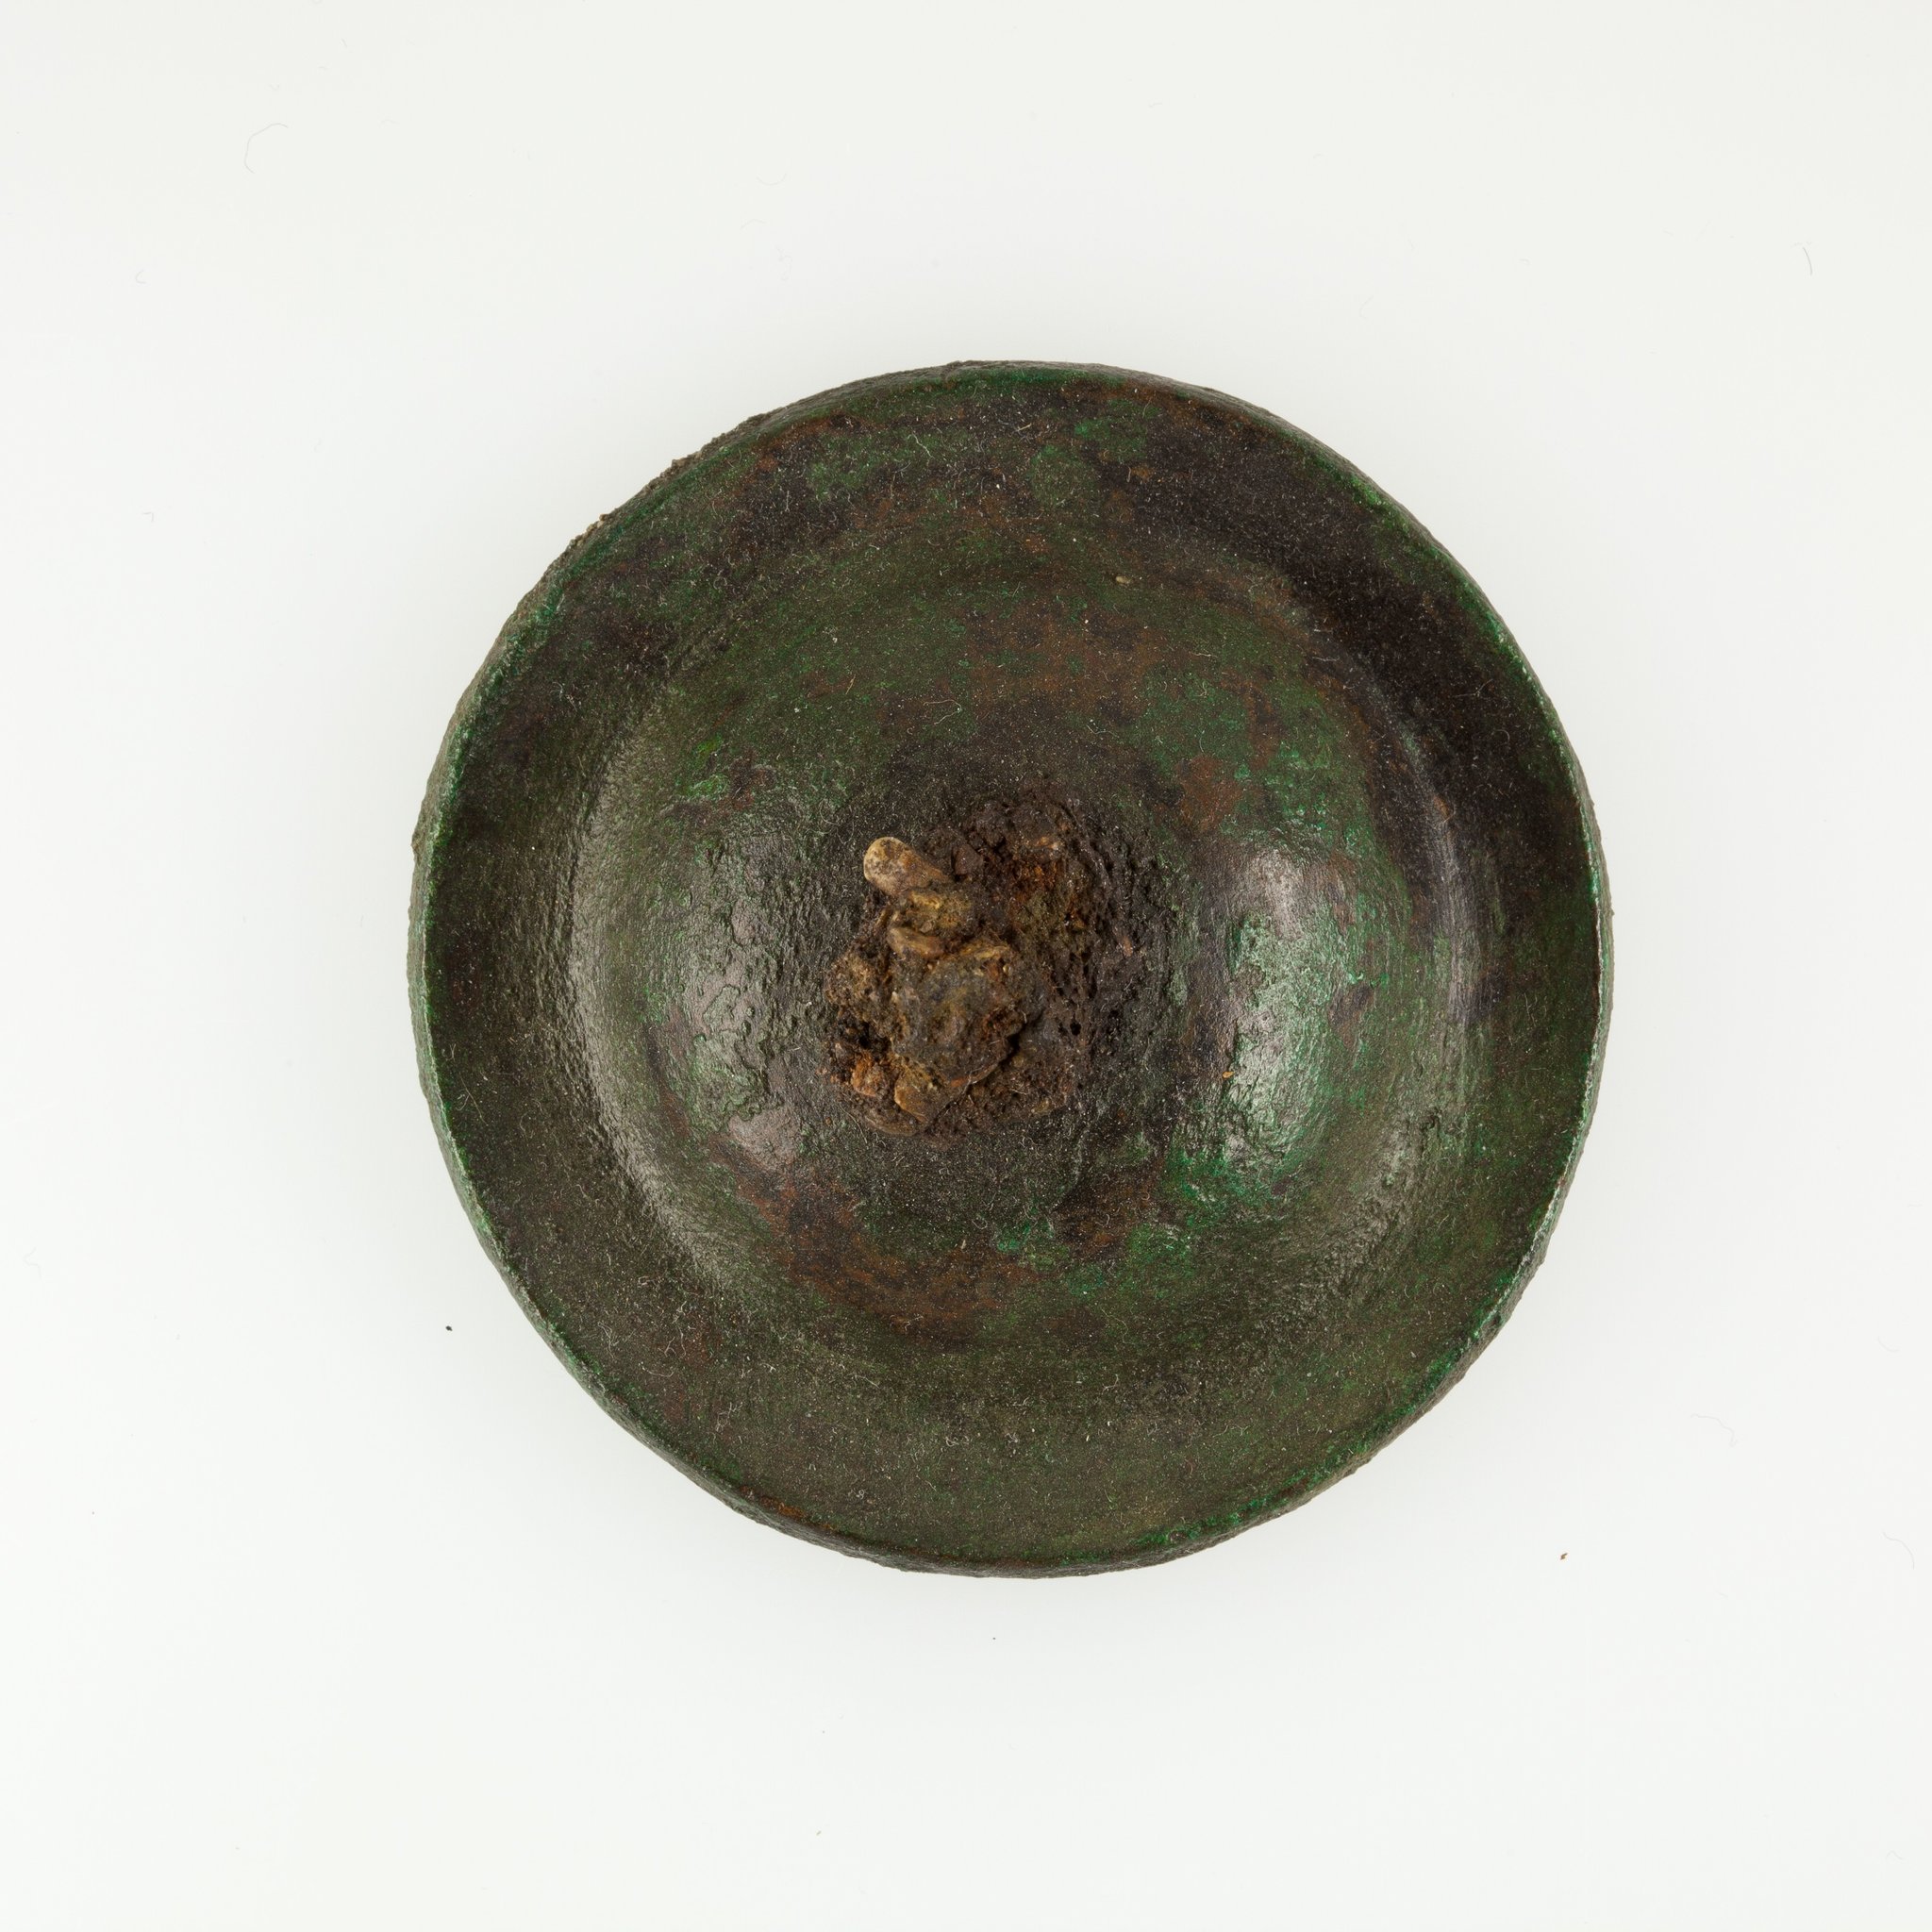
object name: music, cymbal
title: Cymbal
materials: copper alloy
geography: egypt